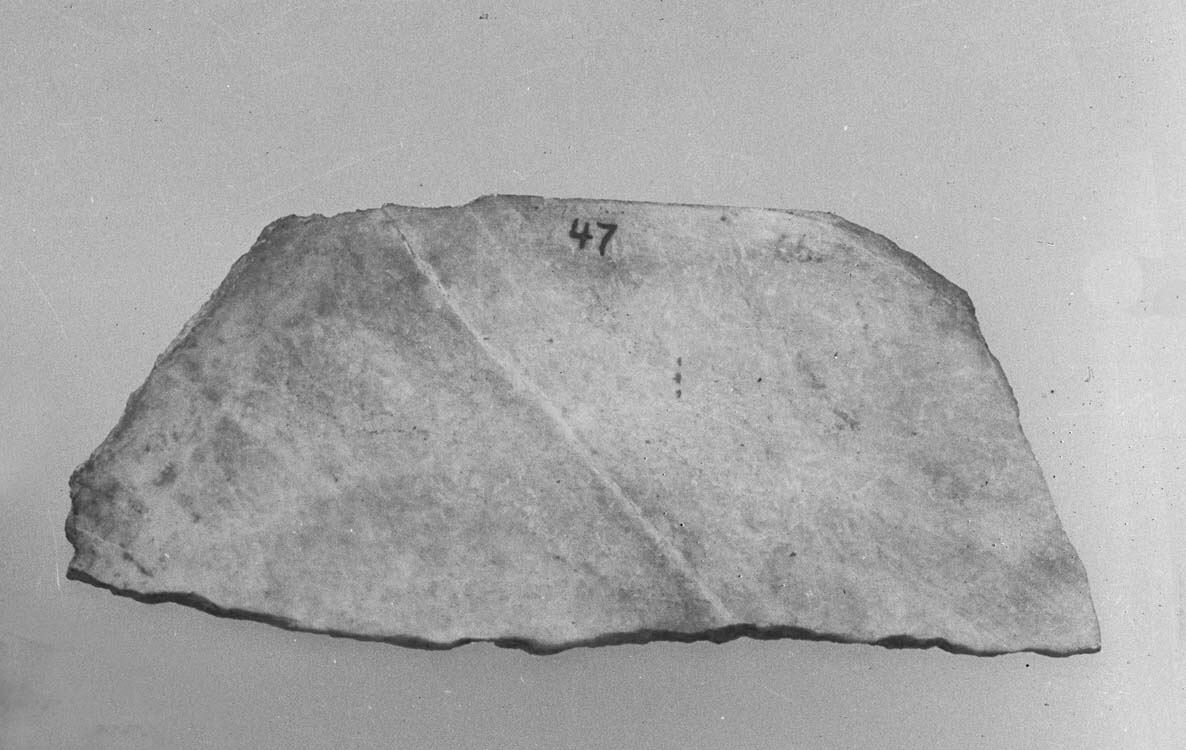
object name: fragment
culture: tibetan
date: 1902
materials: jade